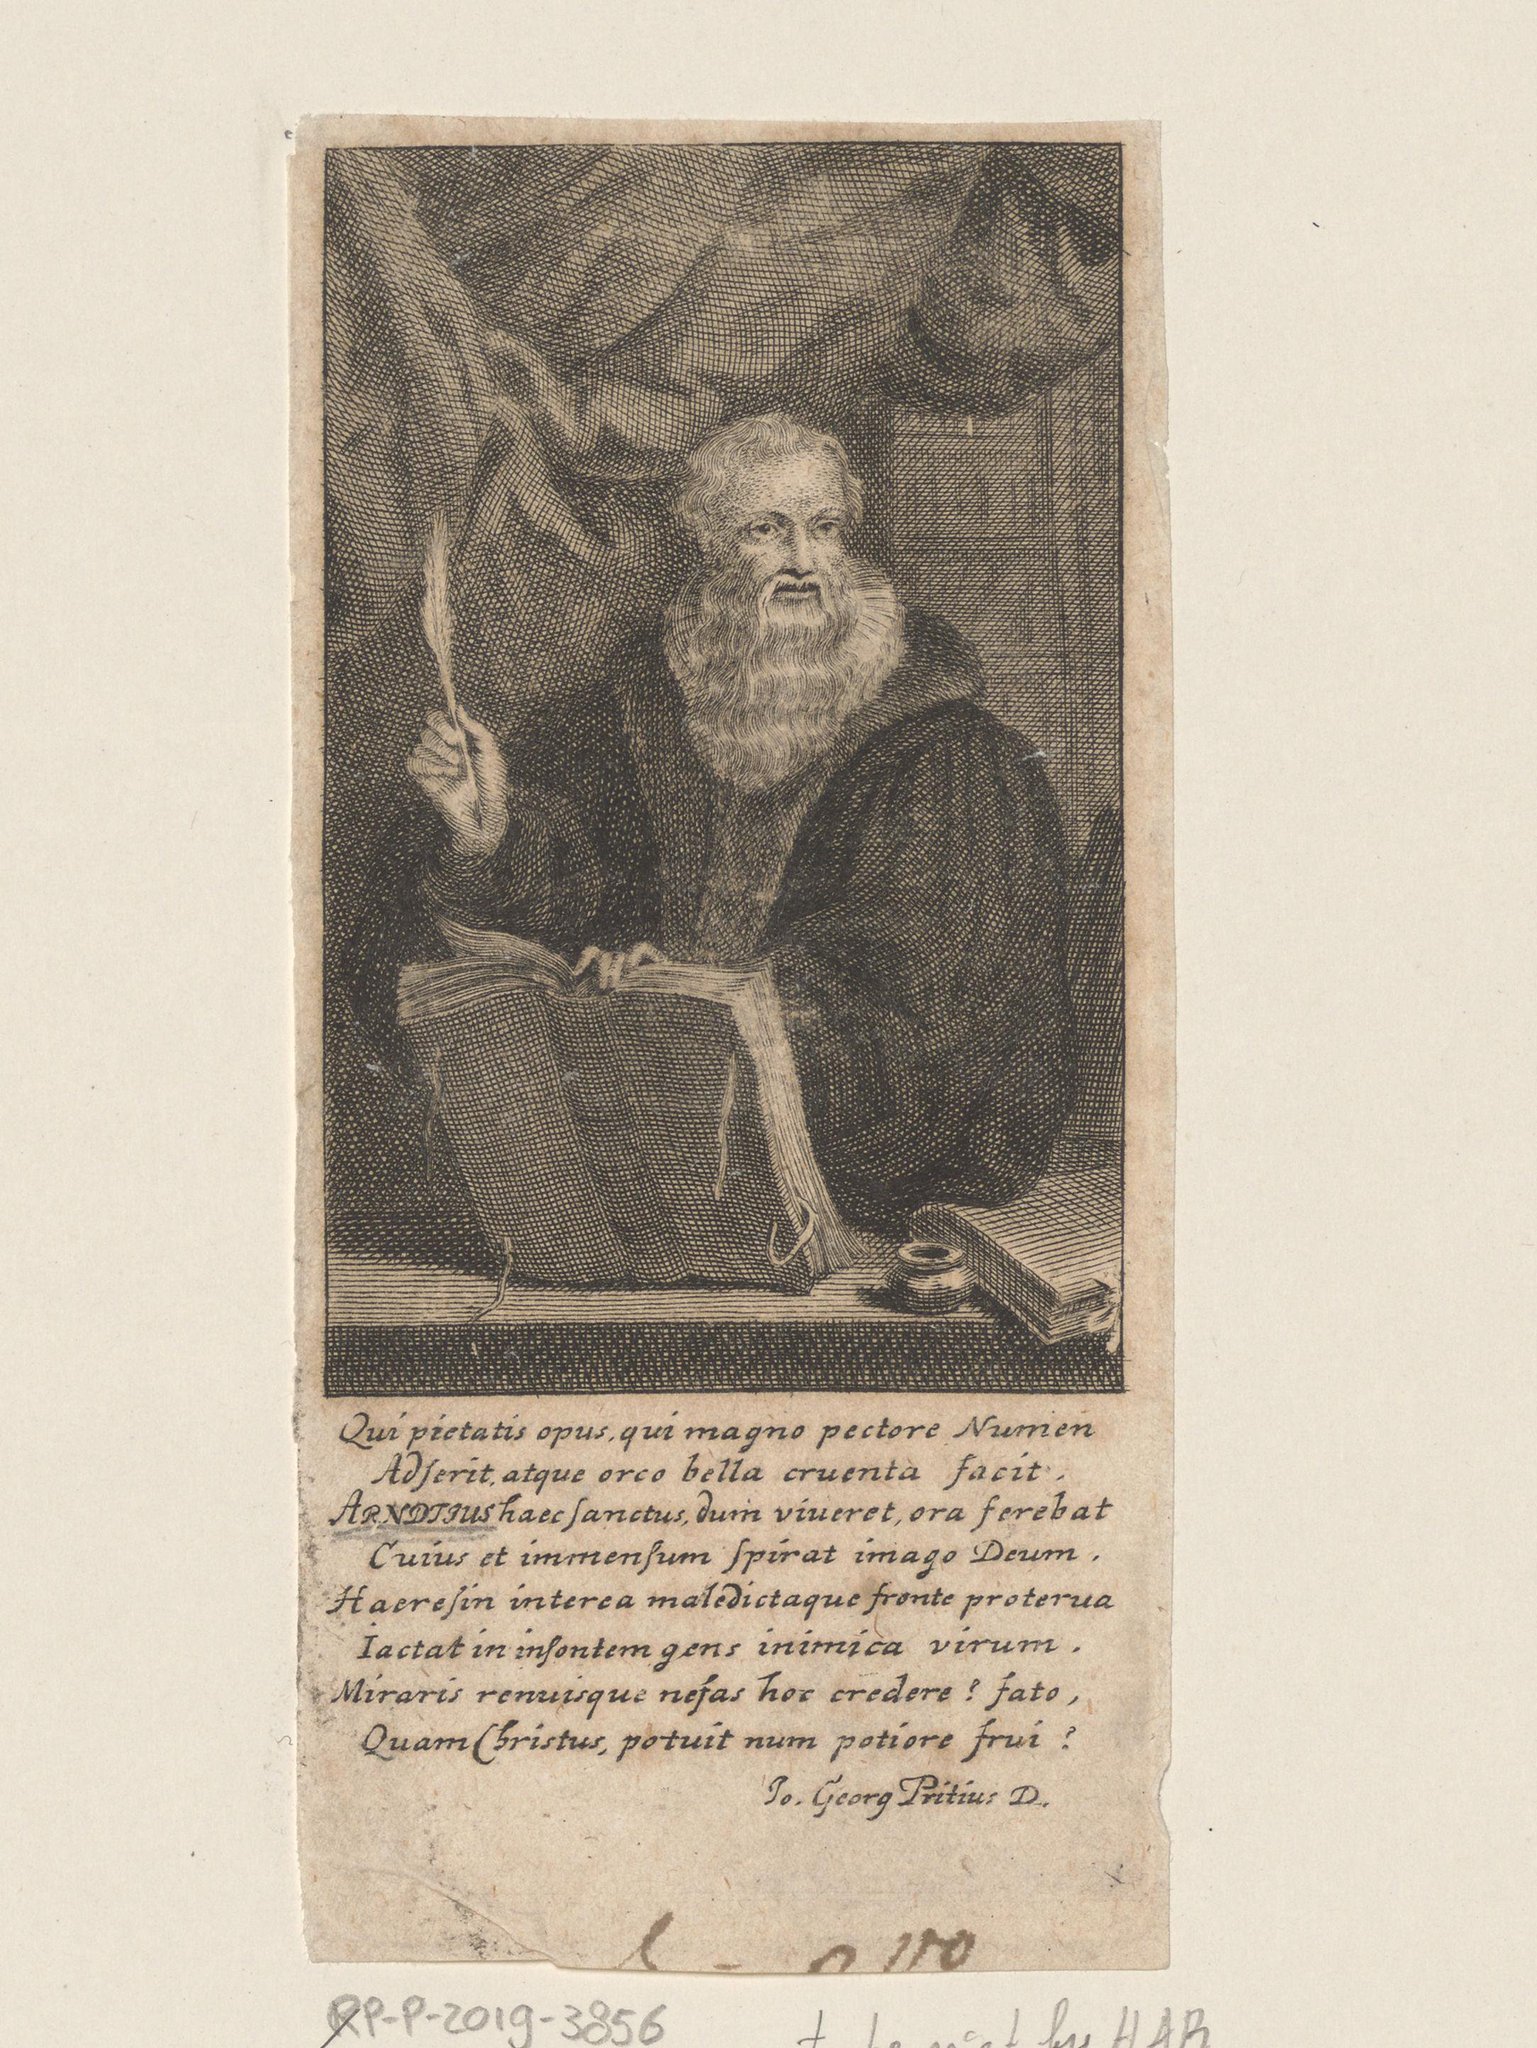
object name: print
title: Portret van Johann Arndt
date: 1700-1749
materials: paper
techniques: etching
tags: theologian, historical persons